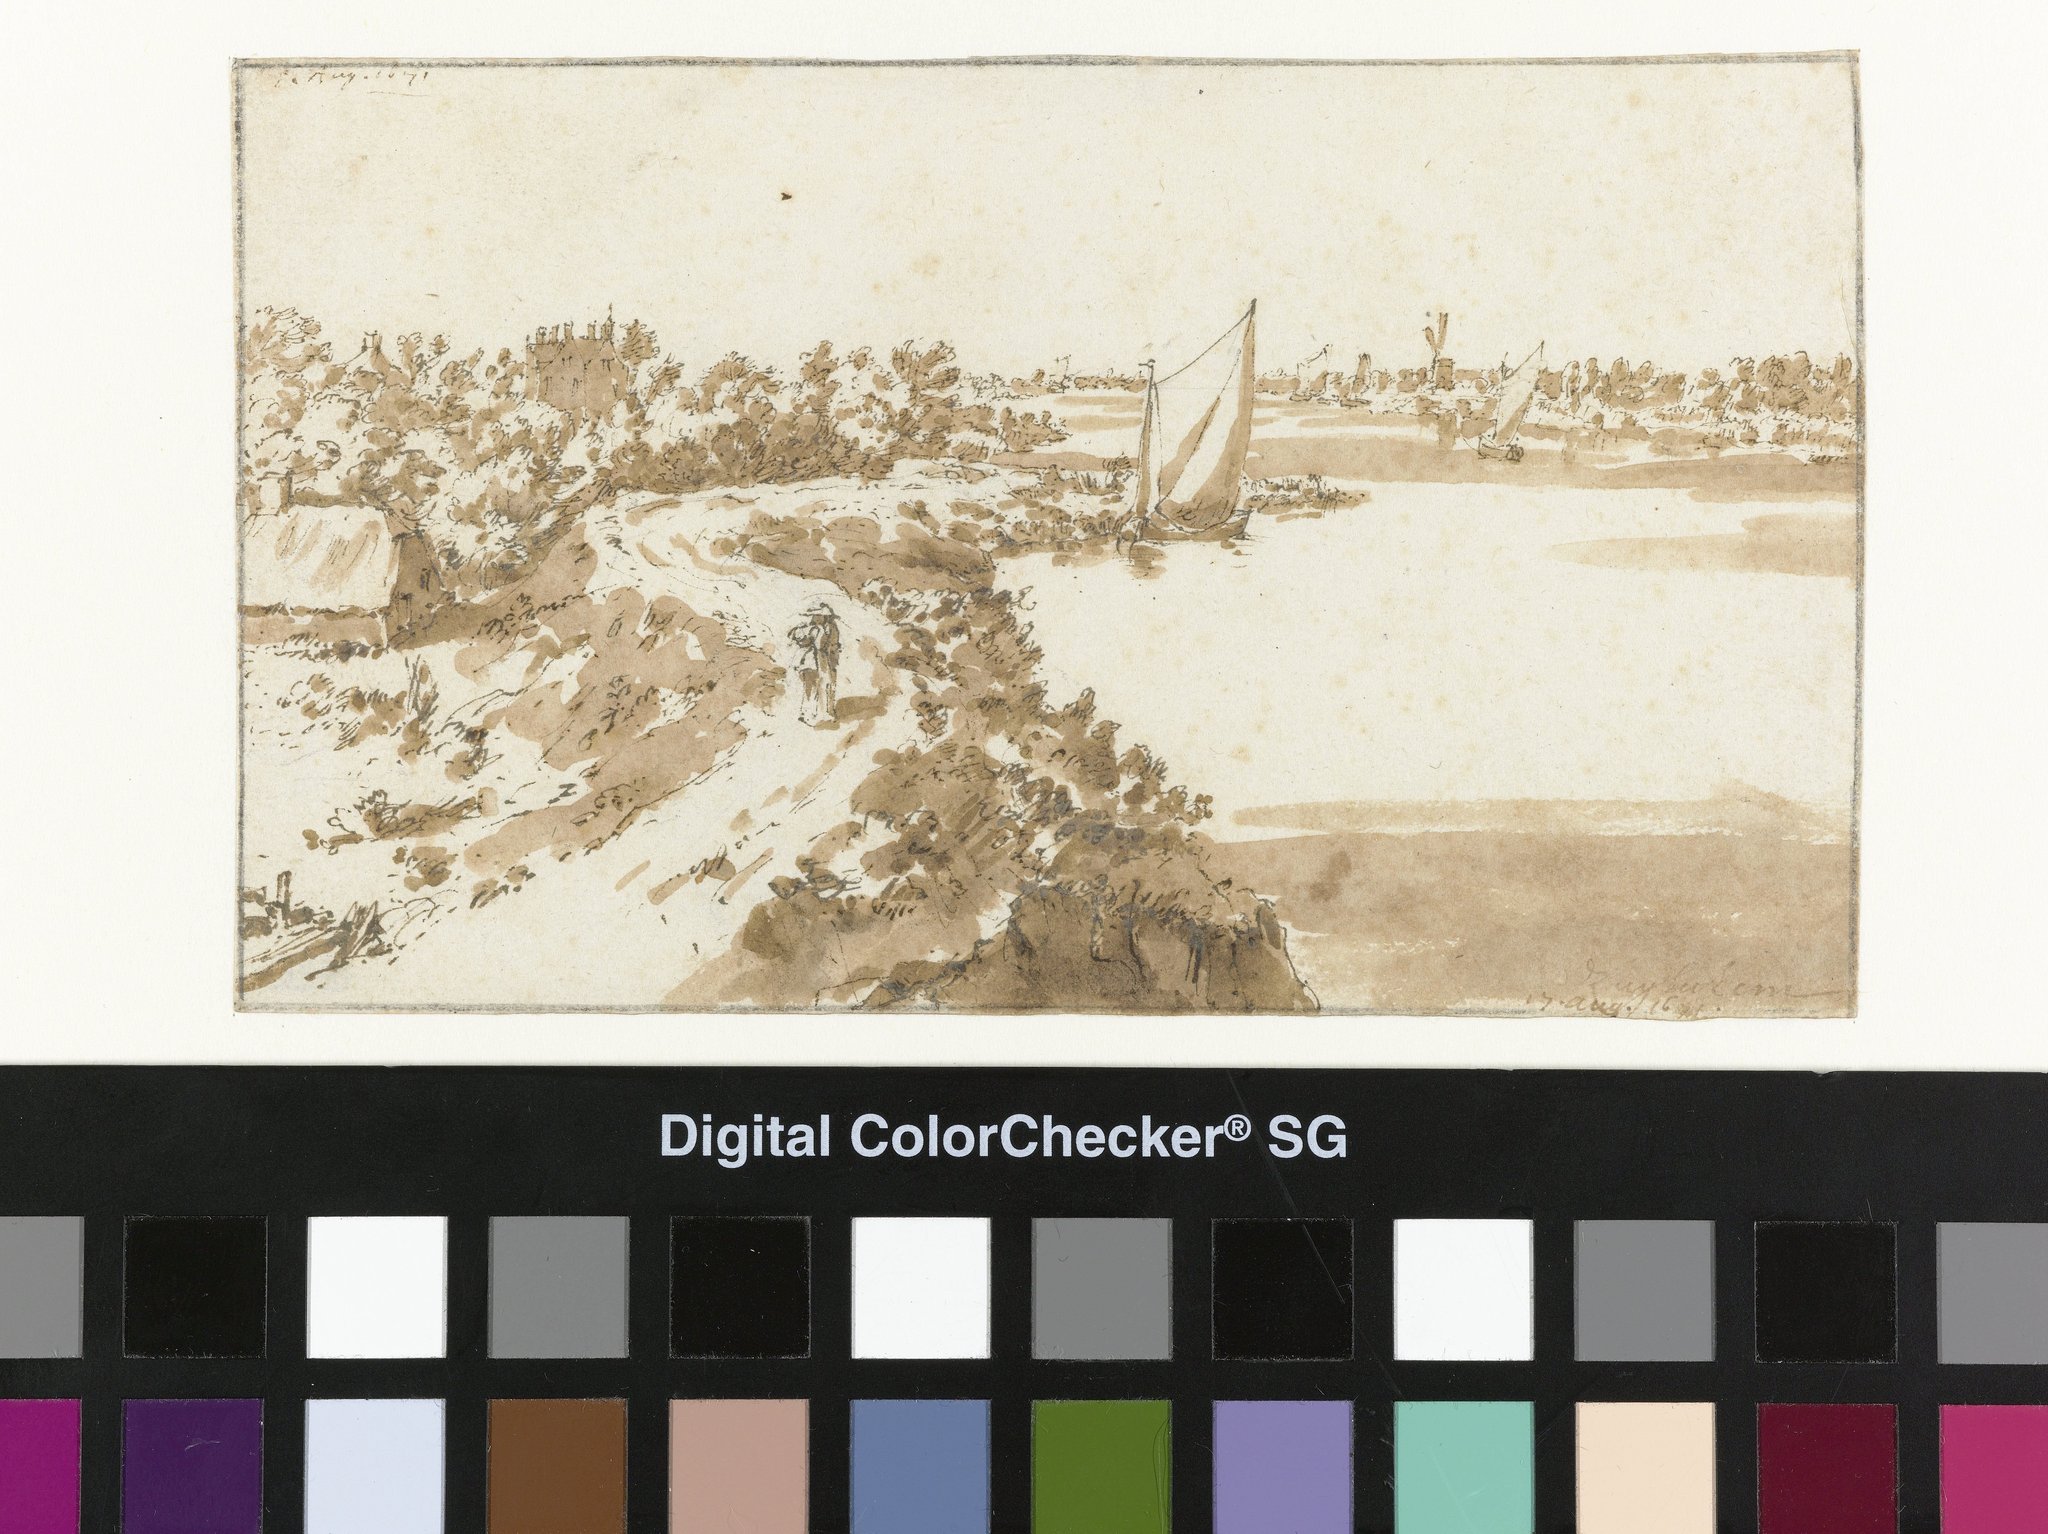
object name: drawing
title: Zuylichem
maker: constantijn huygens (ii)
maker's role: draughtsman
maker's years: 1628-1697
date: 1671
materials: ink, paper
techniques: brush, pen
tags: river